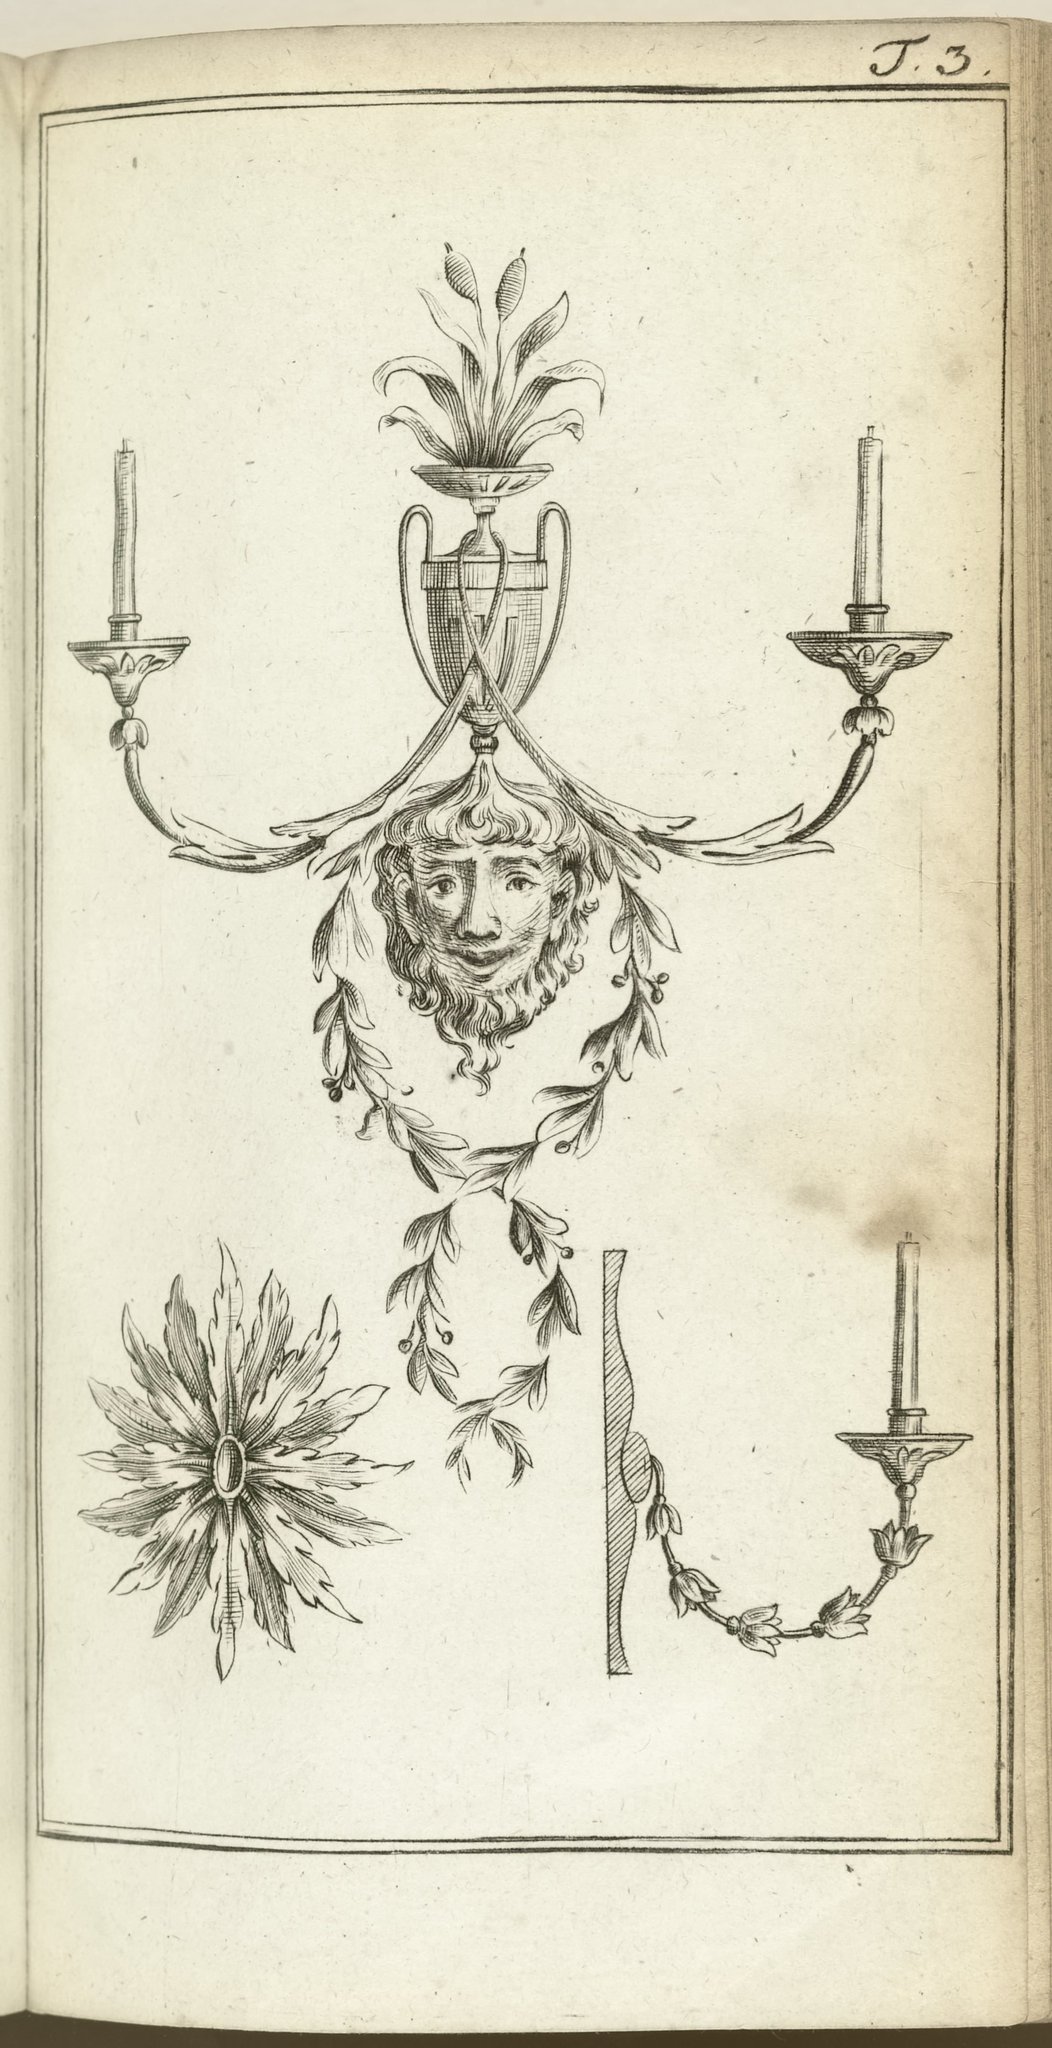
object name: magazine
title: Journal des Luxus und der Moden 1790, Band V, T.3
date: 1790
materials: paper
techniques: etching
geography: weimar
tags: fashion plates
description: Prent uit het modetijdschrift Journal des Luxus und der Moden, uitgegeven door Friedrich Justin Bertuch en Georg Melchior Kraus, Weimar, 1786-1826.